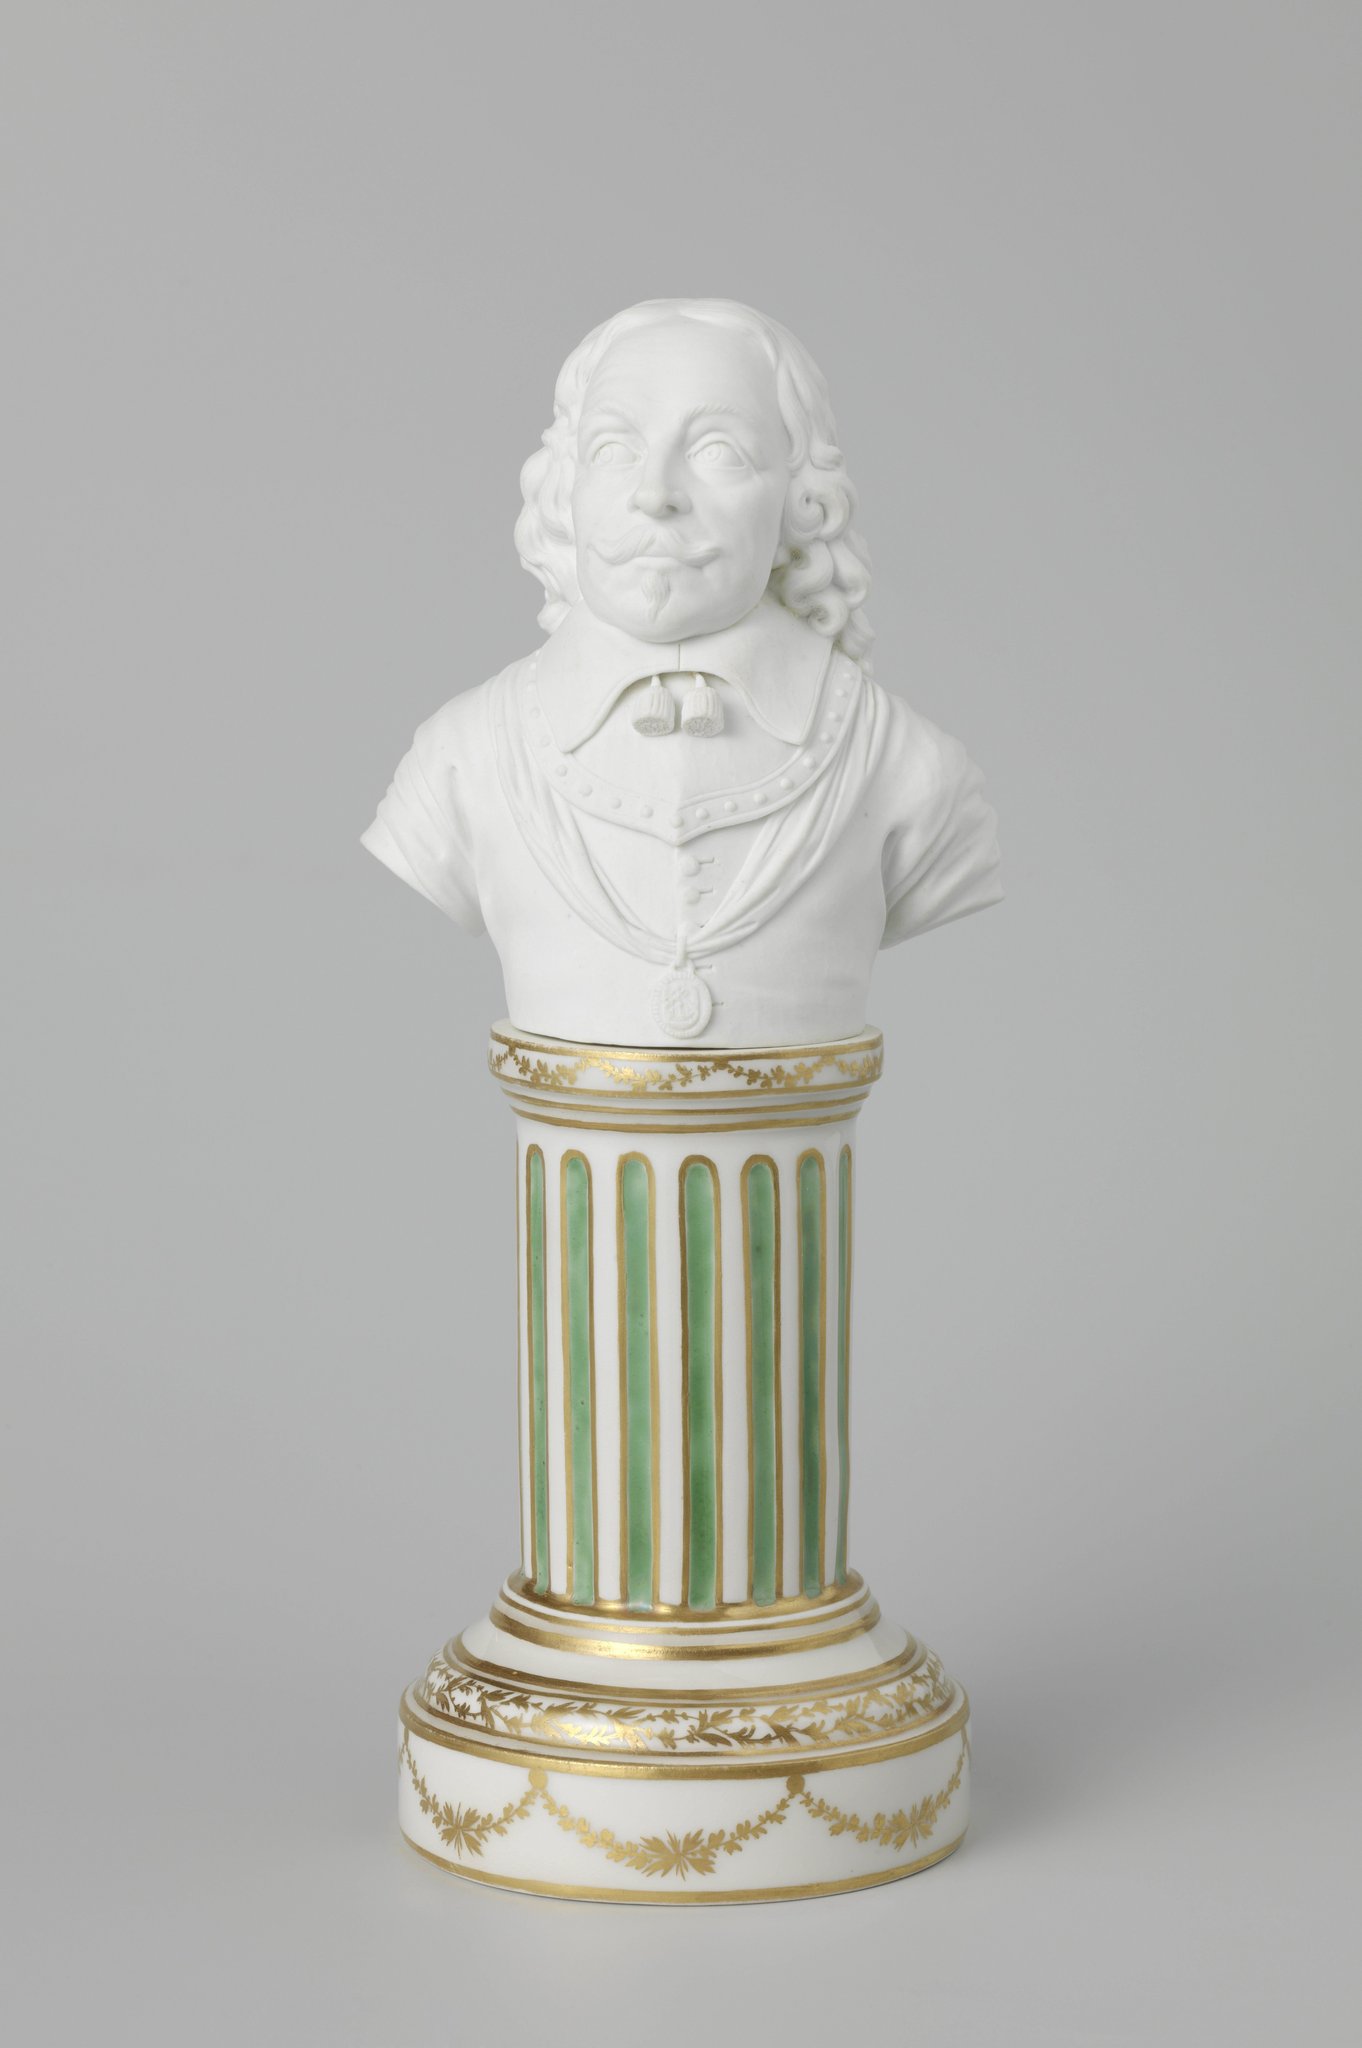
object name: bust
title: Portrait Bust of Maarten Harpertsz. Tromp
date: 1782-1784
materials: biscuit porcelain, glaze, material), porcelain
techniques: gilding, vitrification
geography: loosdrecht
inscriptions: factory mark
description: Buste van Loosdrechts porselein op een voetstuk in de vorm van een zuil met groene cannelures en vergulding, voorstellend Maarten Harpertsz. Tromp.